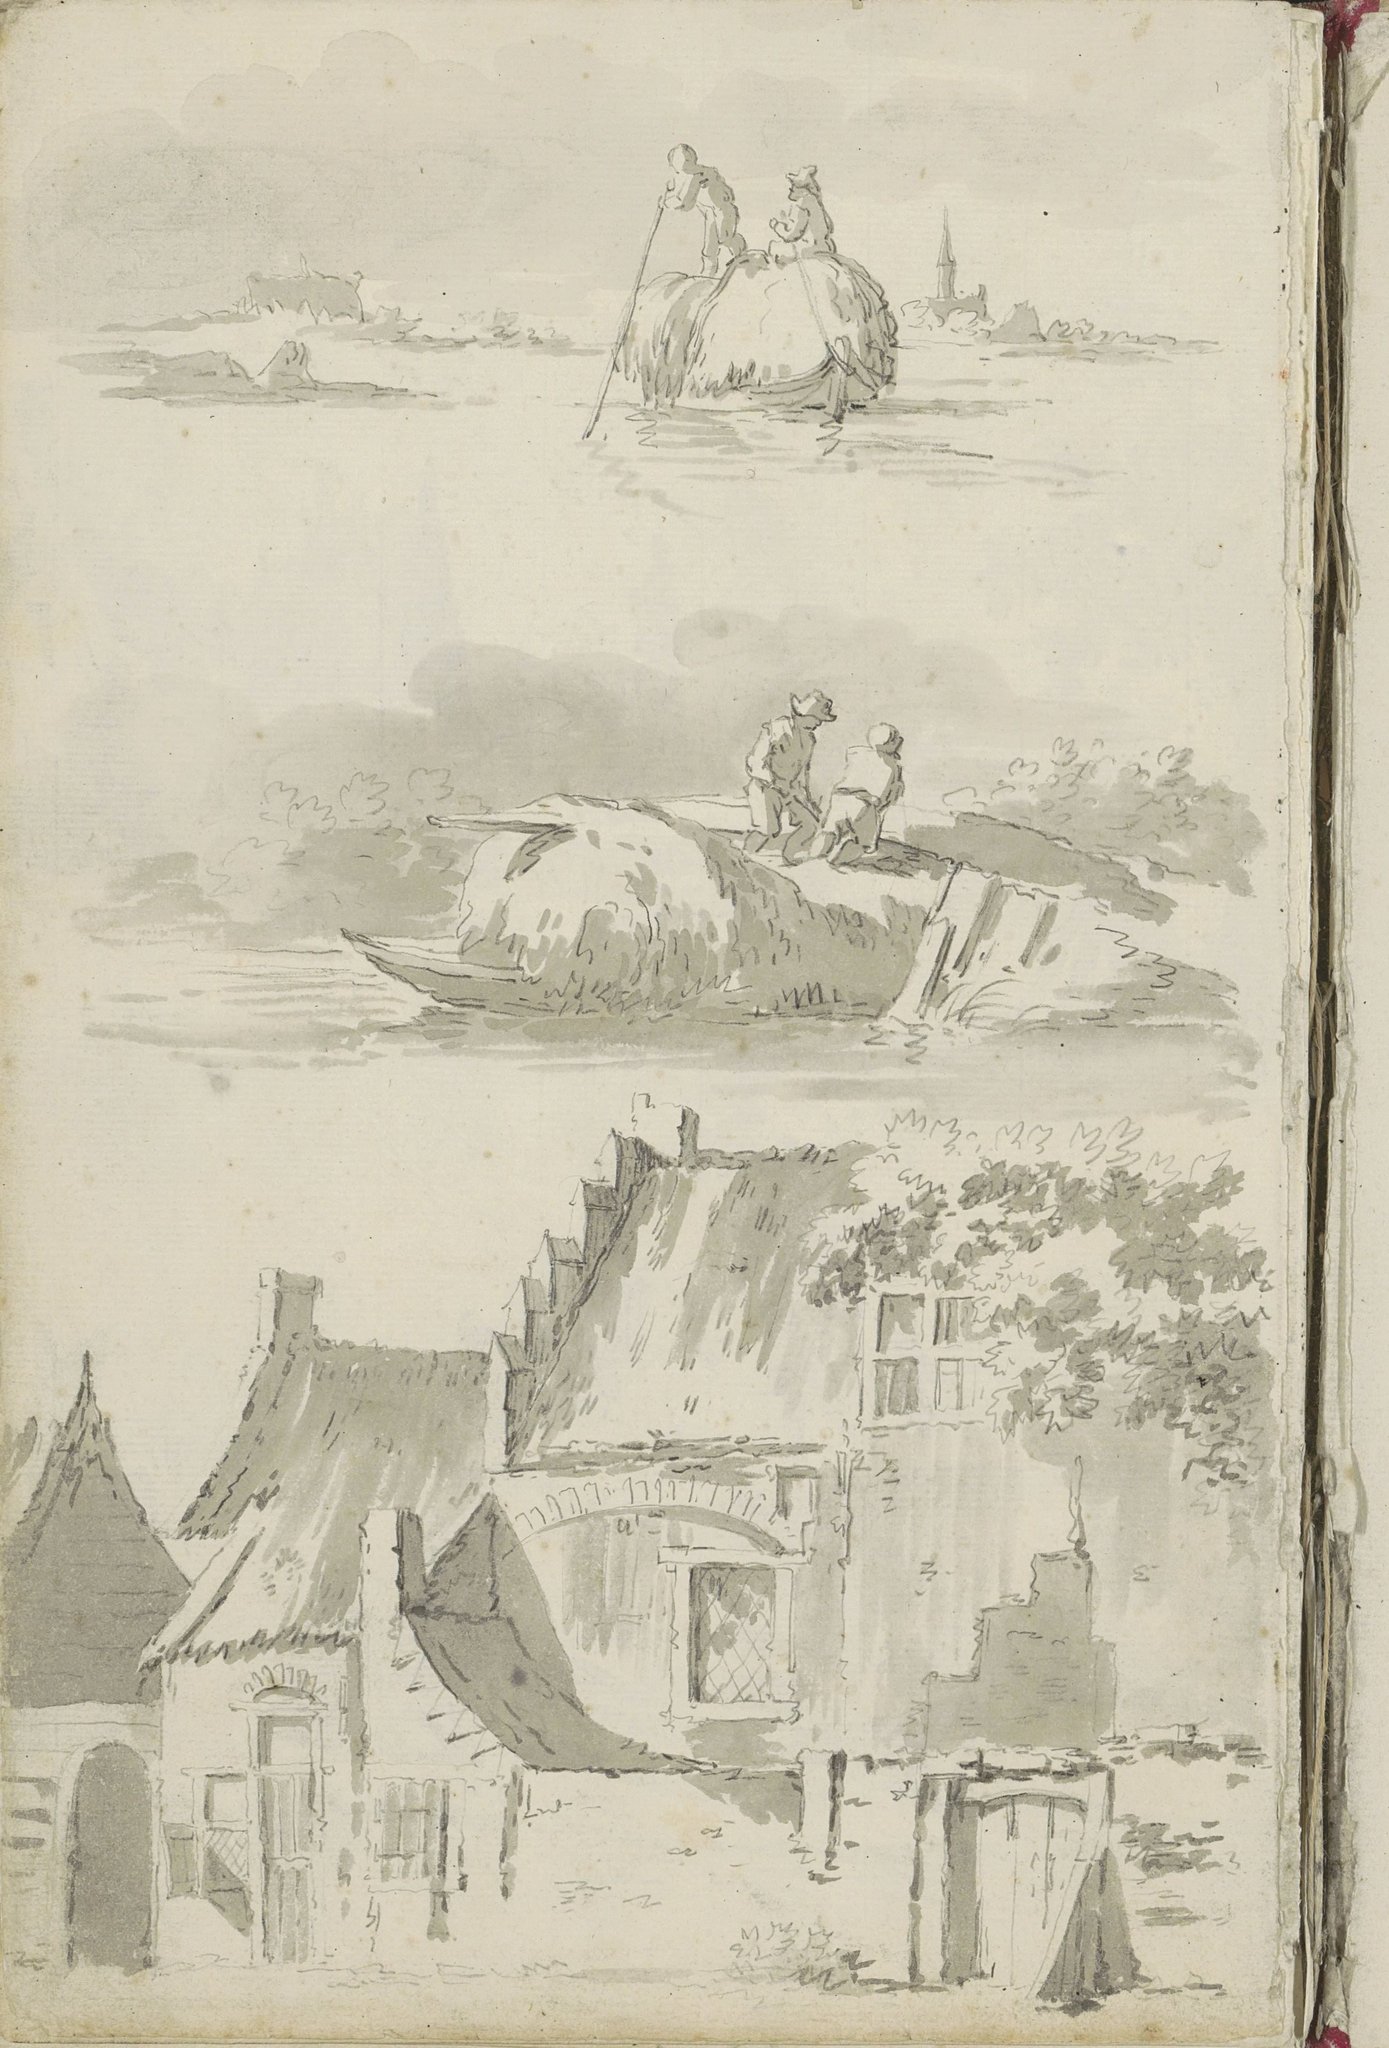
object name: sketchbook leaf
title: Twee figuren met een hooibaal in een roeiboot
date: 1780-1800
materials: paper, pencil, watercolor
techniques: brush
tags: agricultural products and by-products: hay, rowing-boat, canoe, etc.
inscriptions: annotation: ‘agt bossen’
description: Tevens een studie van woningen. Blad 6 verso uit een schetsboek met 25 bladen.